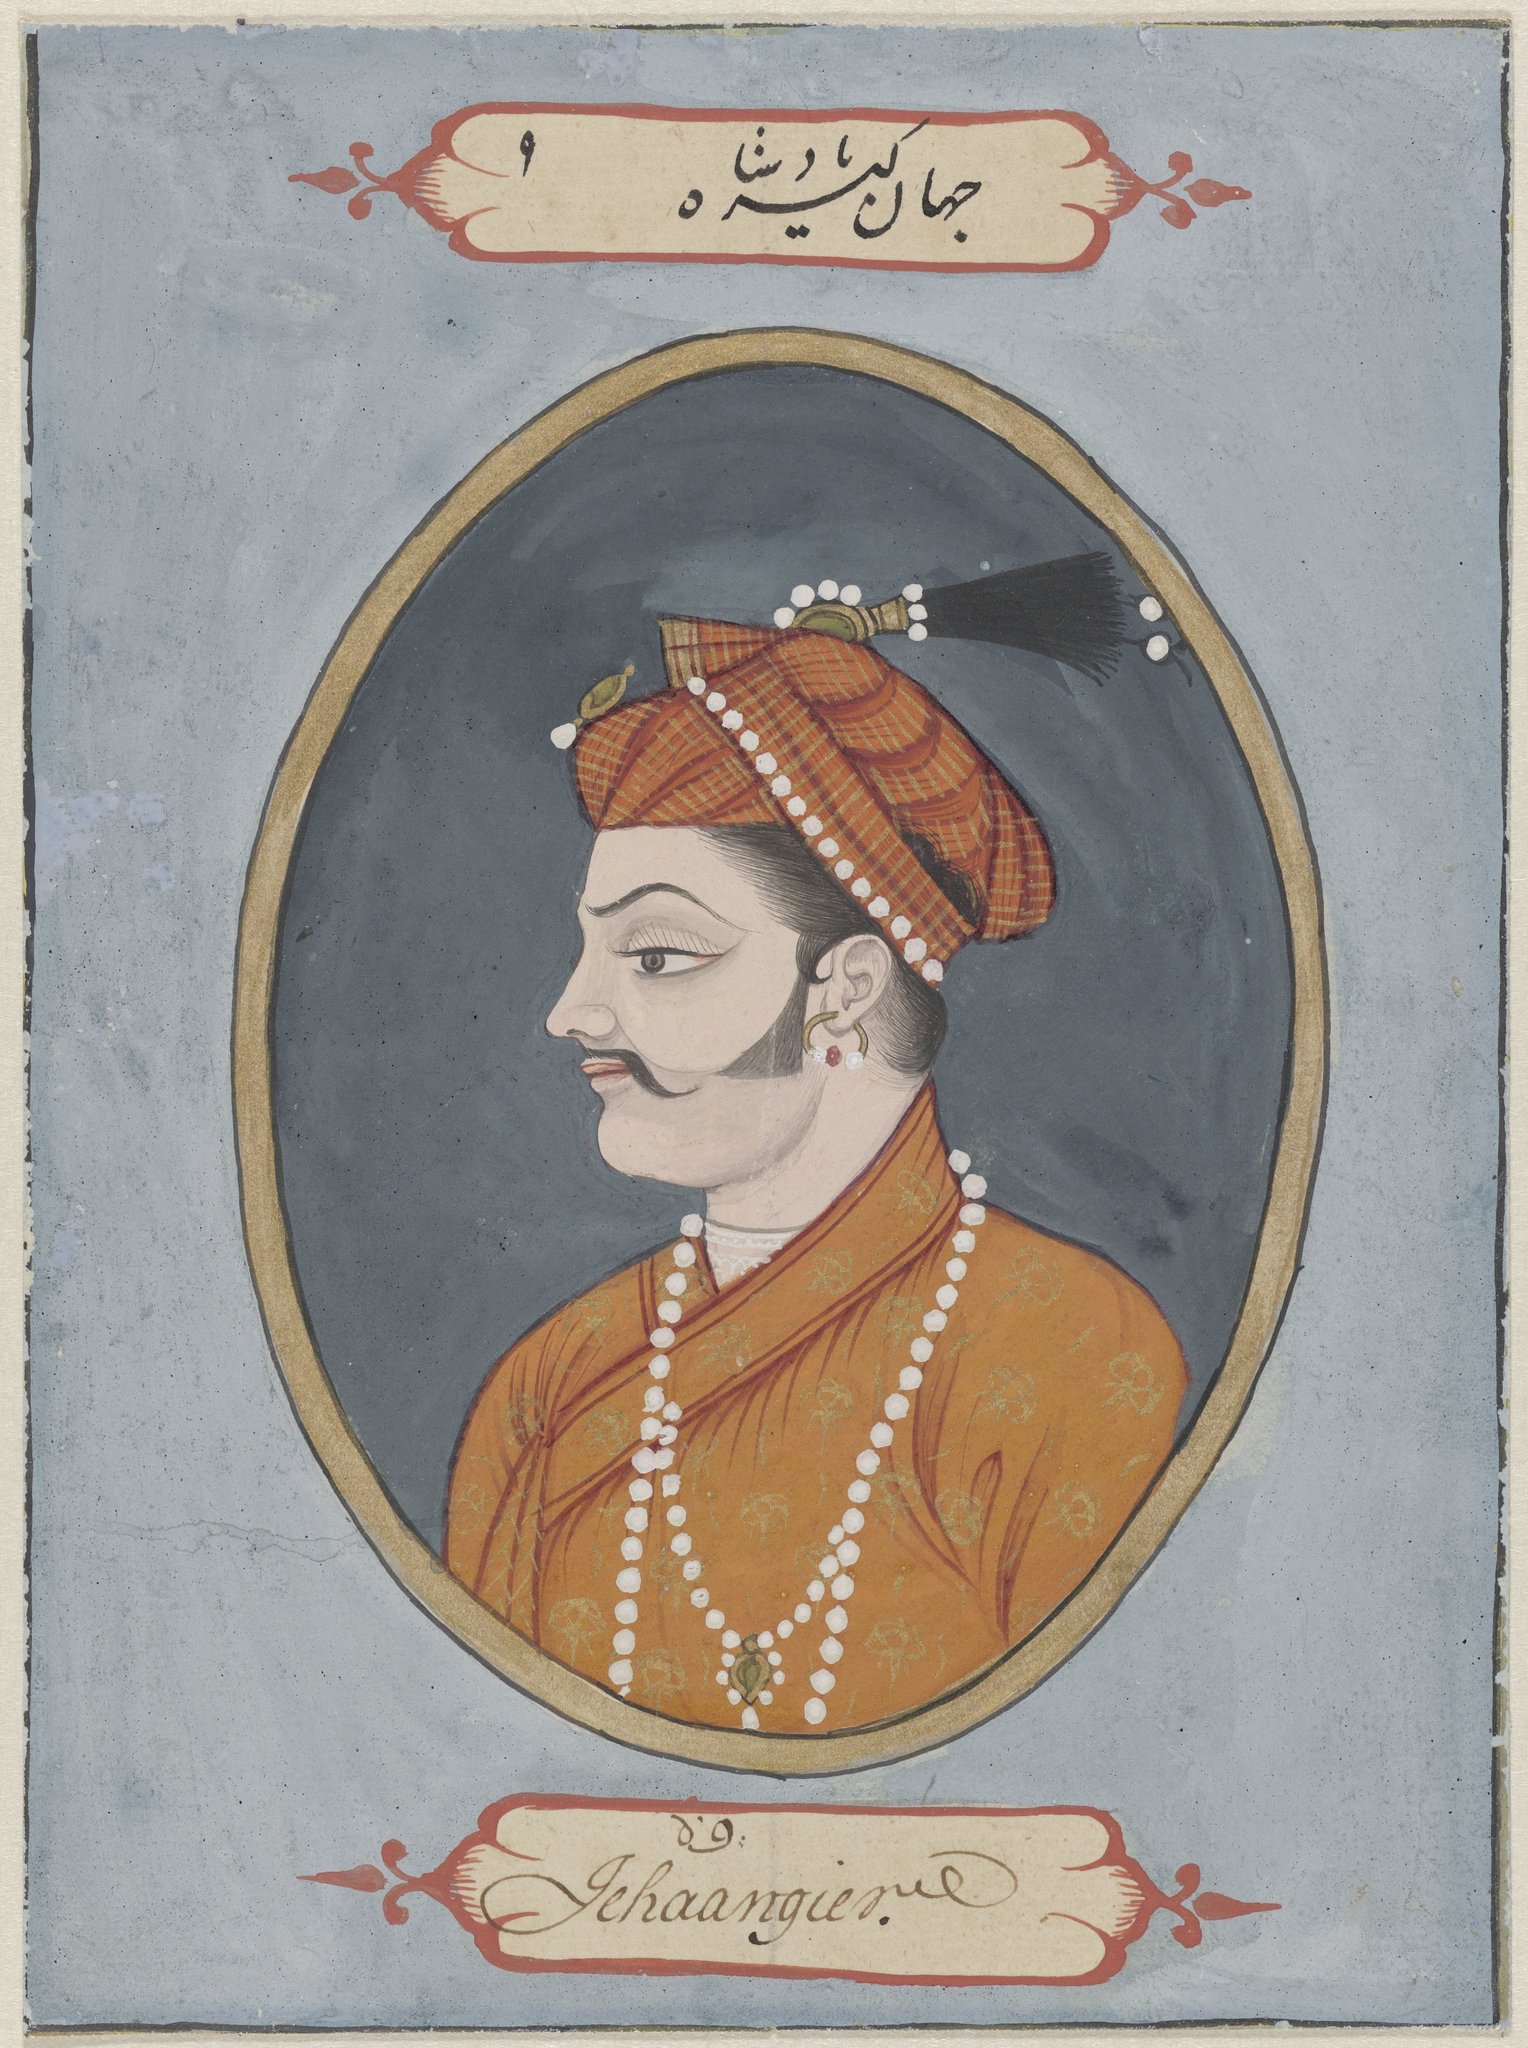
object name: drawing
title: Portret van de grootmogol Jehangir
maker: Anonymous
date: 1720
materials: paint, paper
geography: deccan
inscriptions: inscription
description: Afgesneden aan de randen; was bij aankoop ingelijst.